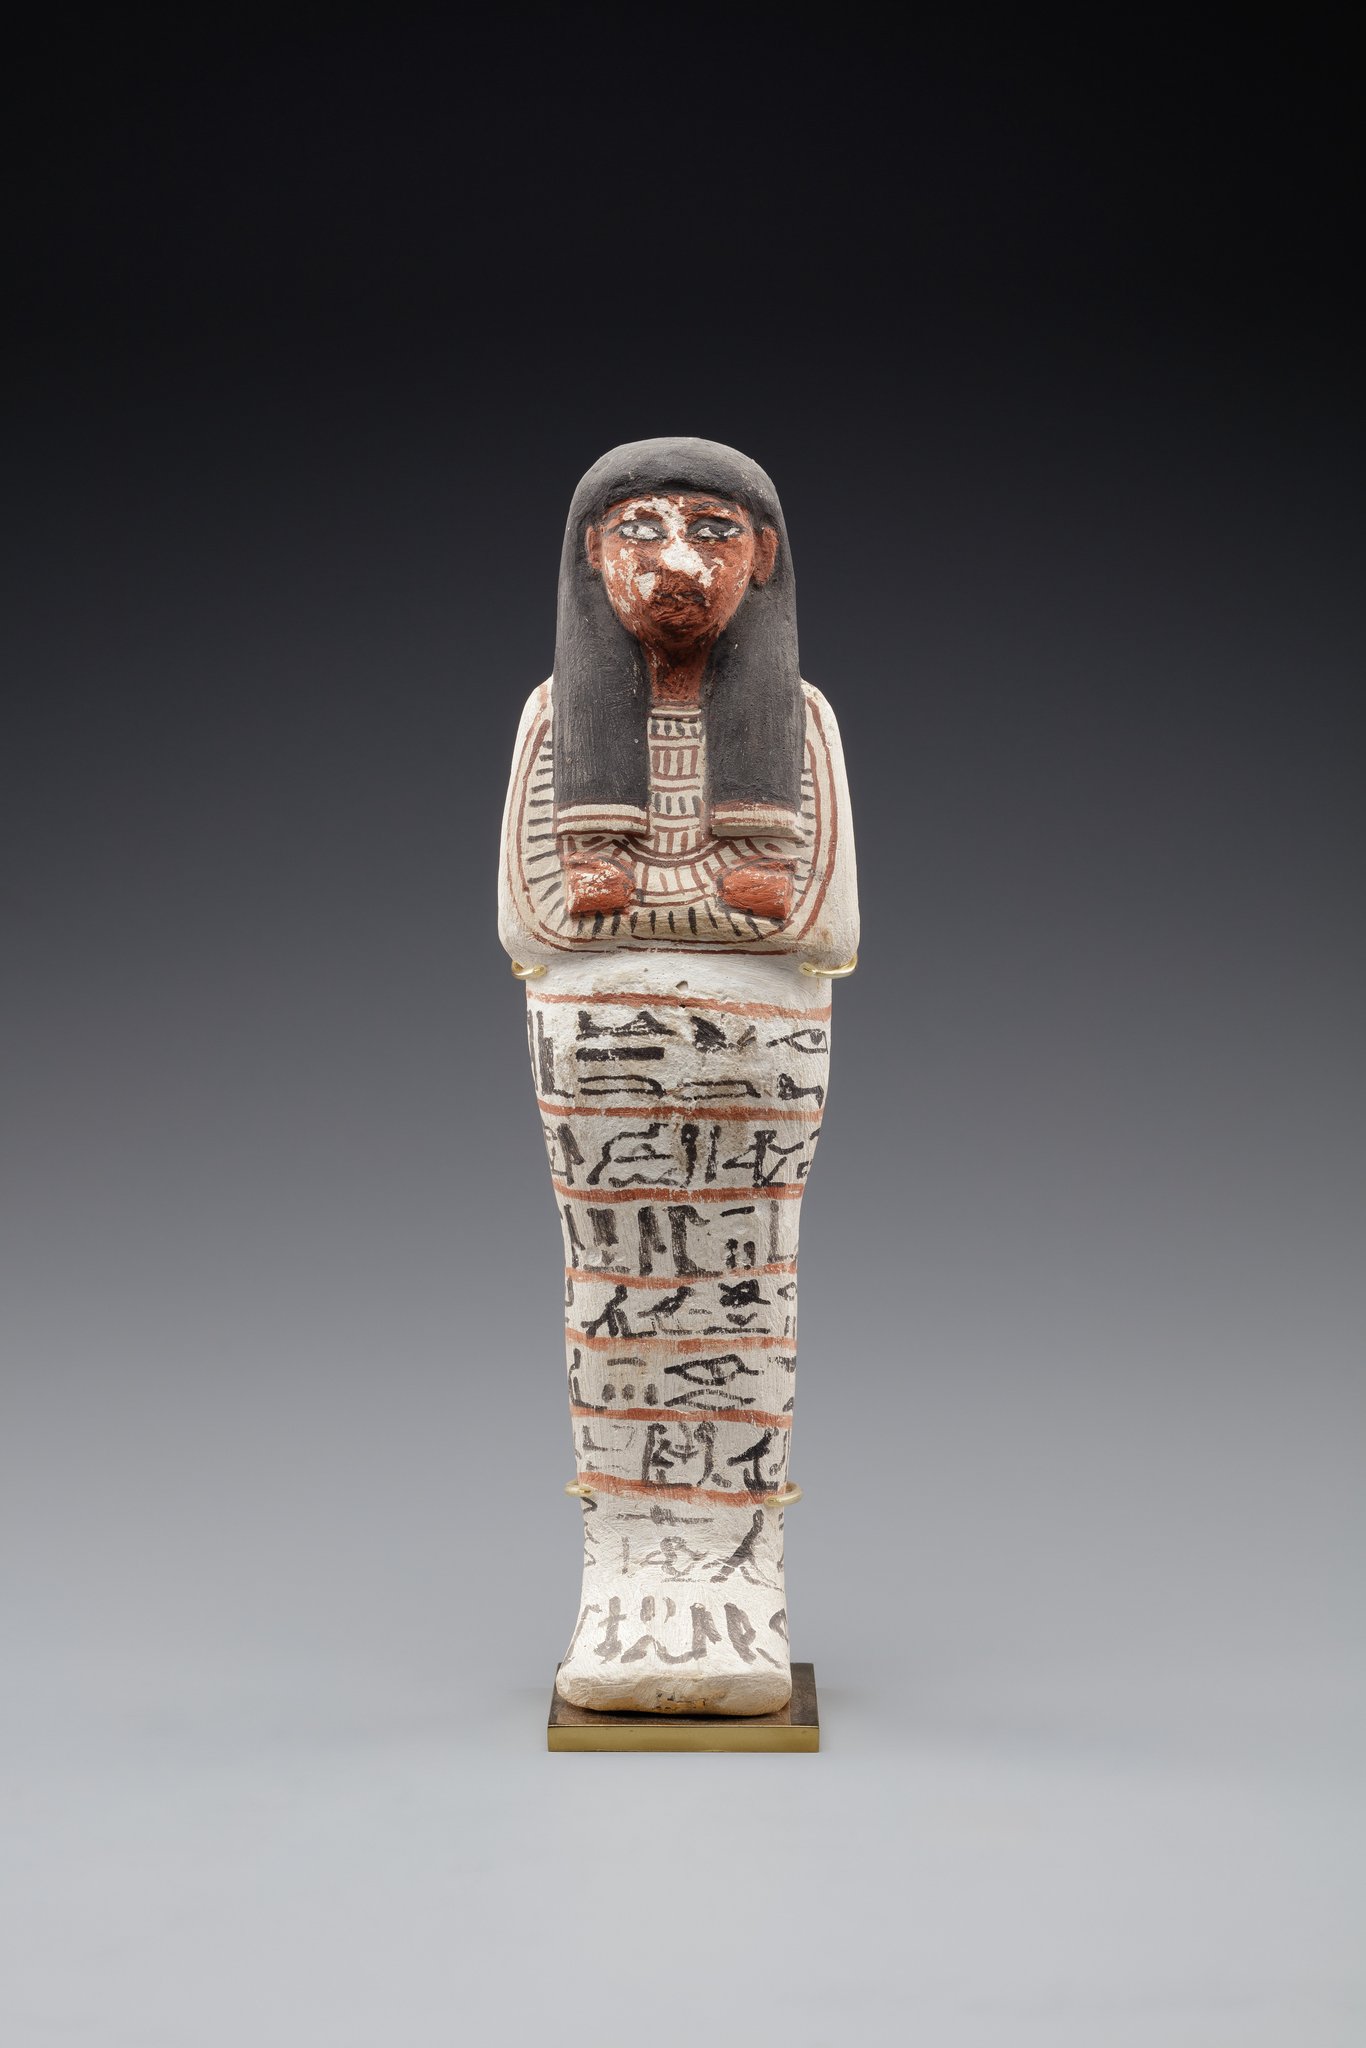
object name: shabti, khabekhnet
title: Shabti of Khabekhnet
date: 1279-1213 BCE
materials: limestone, paint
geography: egypt